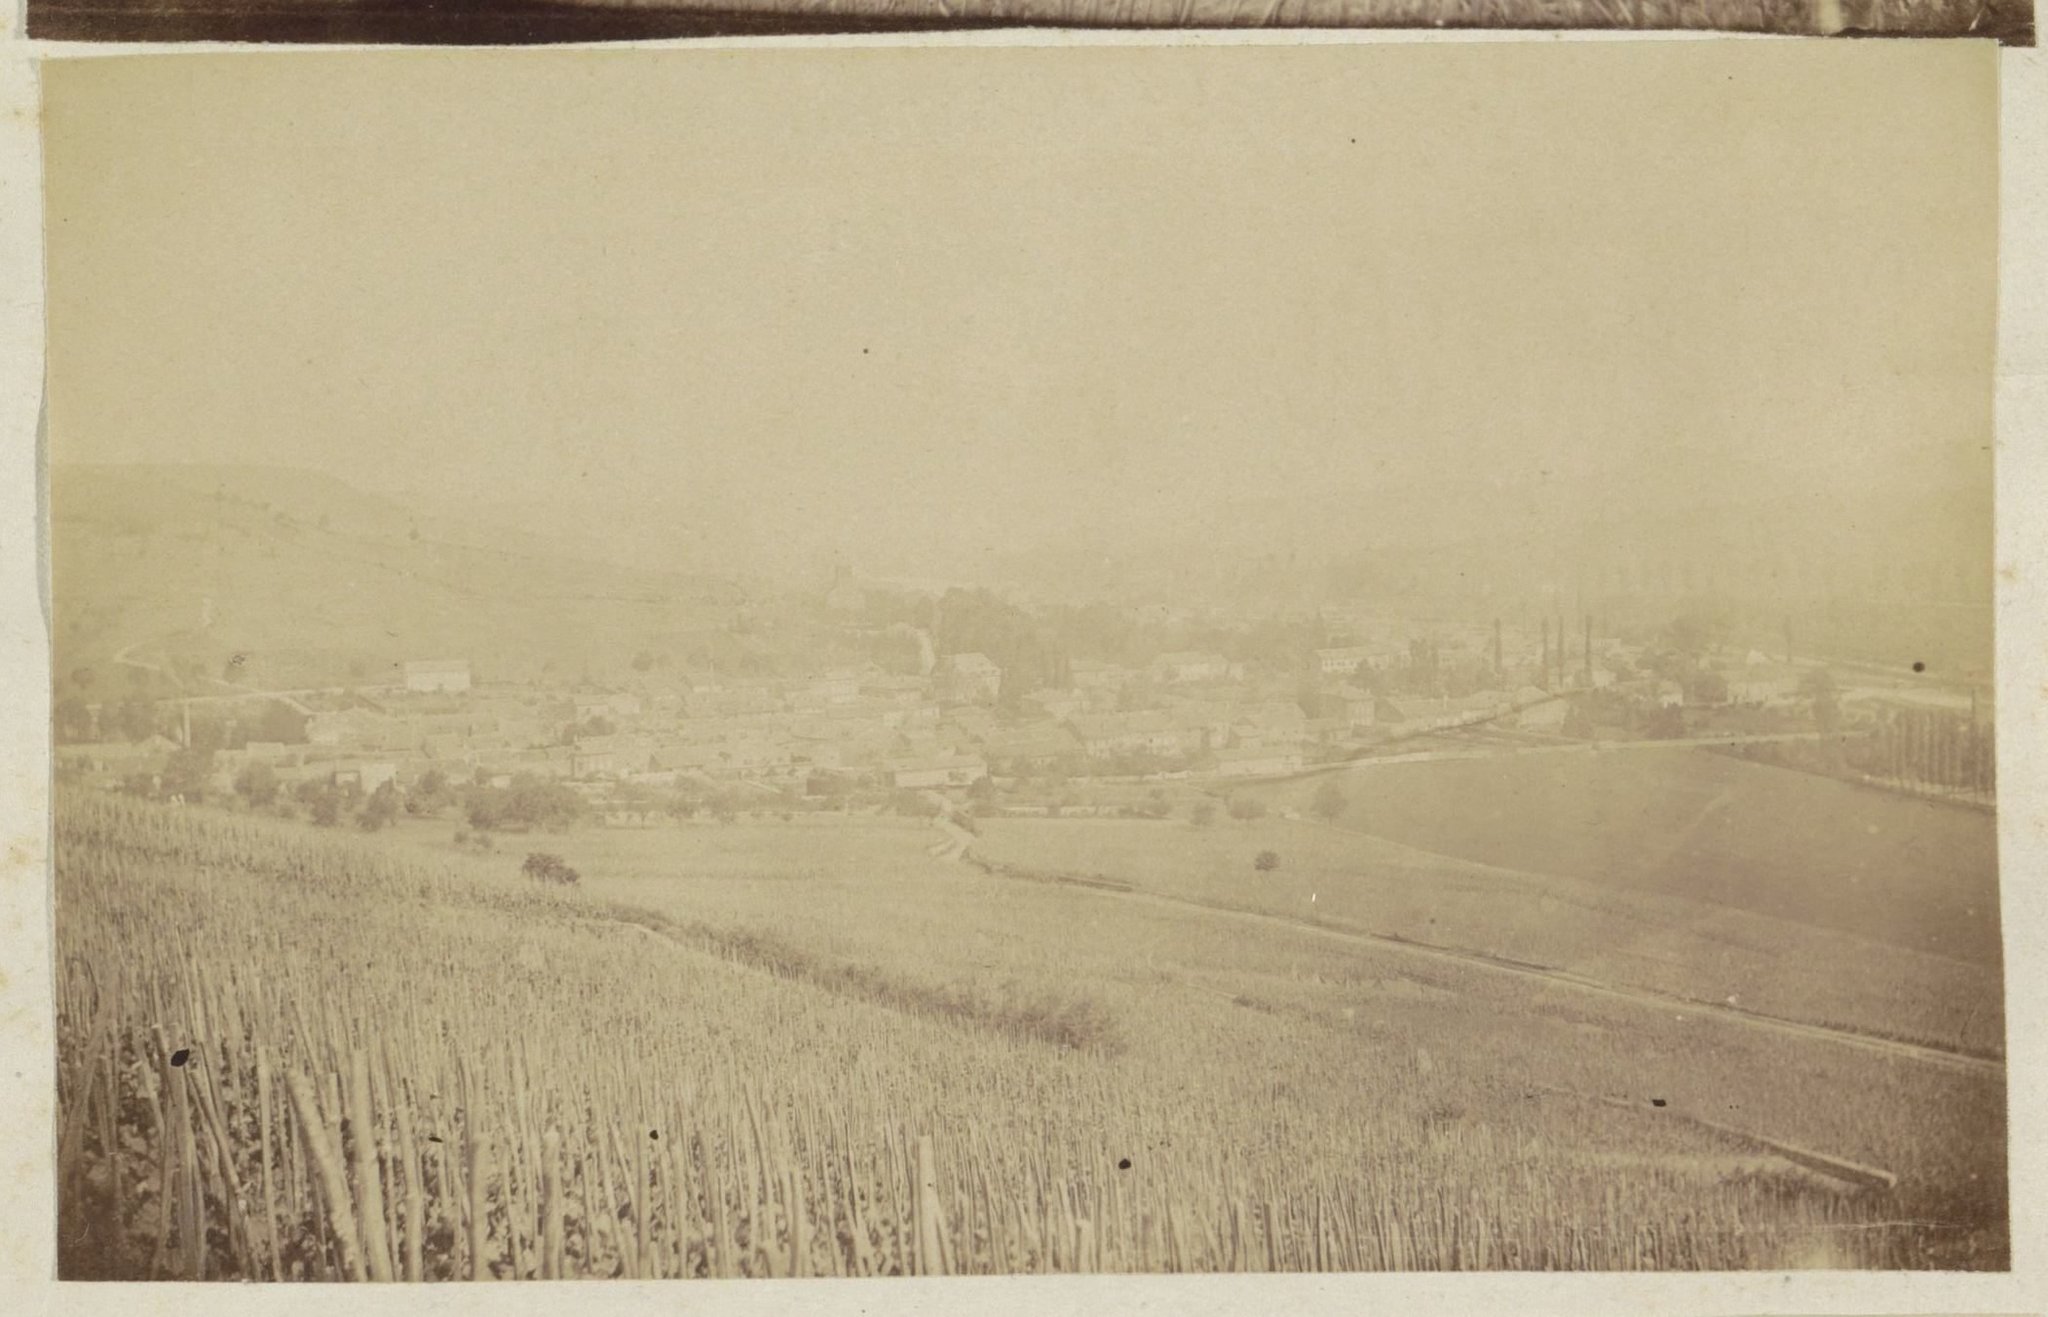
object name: photograph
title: Glooiend landschap met akkers en een dorp in Frankrijk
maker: Anonymous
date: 1805-1884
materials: photographic support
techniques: albumen print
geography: france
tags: prospect of village, silhouette of village, field filled with a crop, landscapes in the temperate zone, france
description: Onderdeel van Album van een Franse amateurfotograaf met opnames van familie, militairen, industrie, landschappen en bezienswaardigheden in Frankrijk.